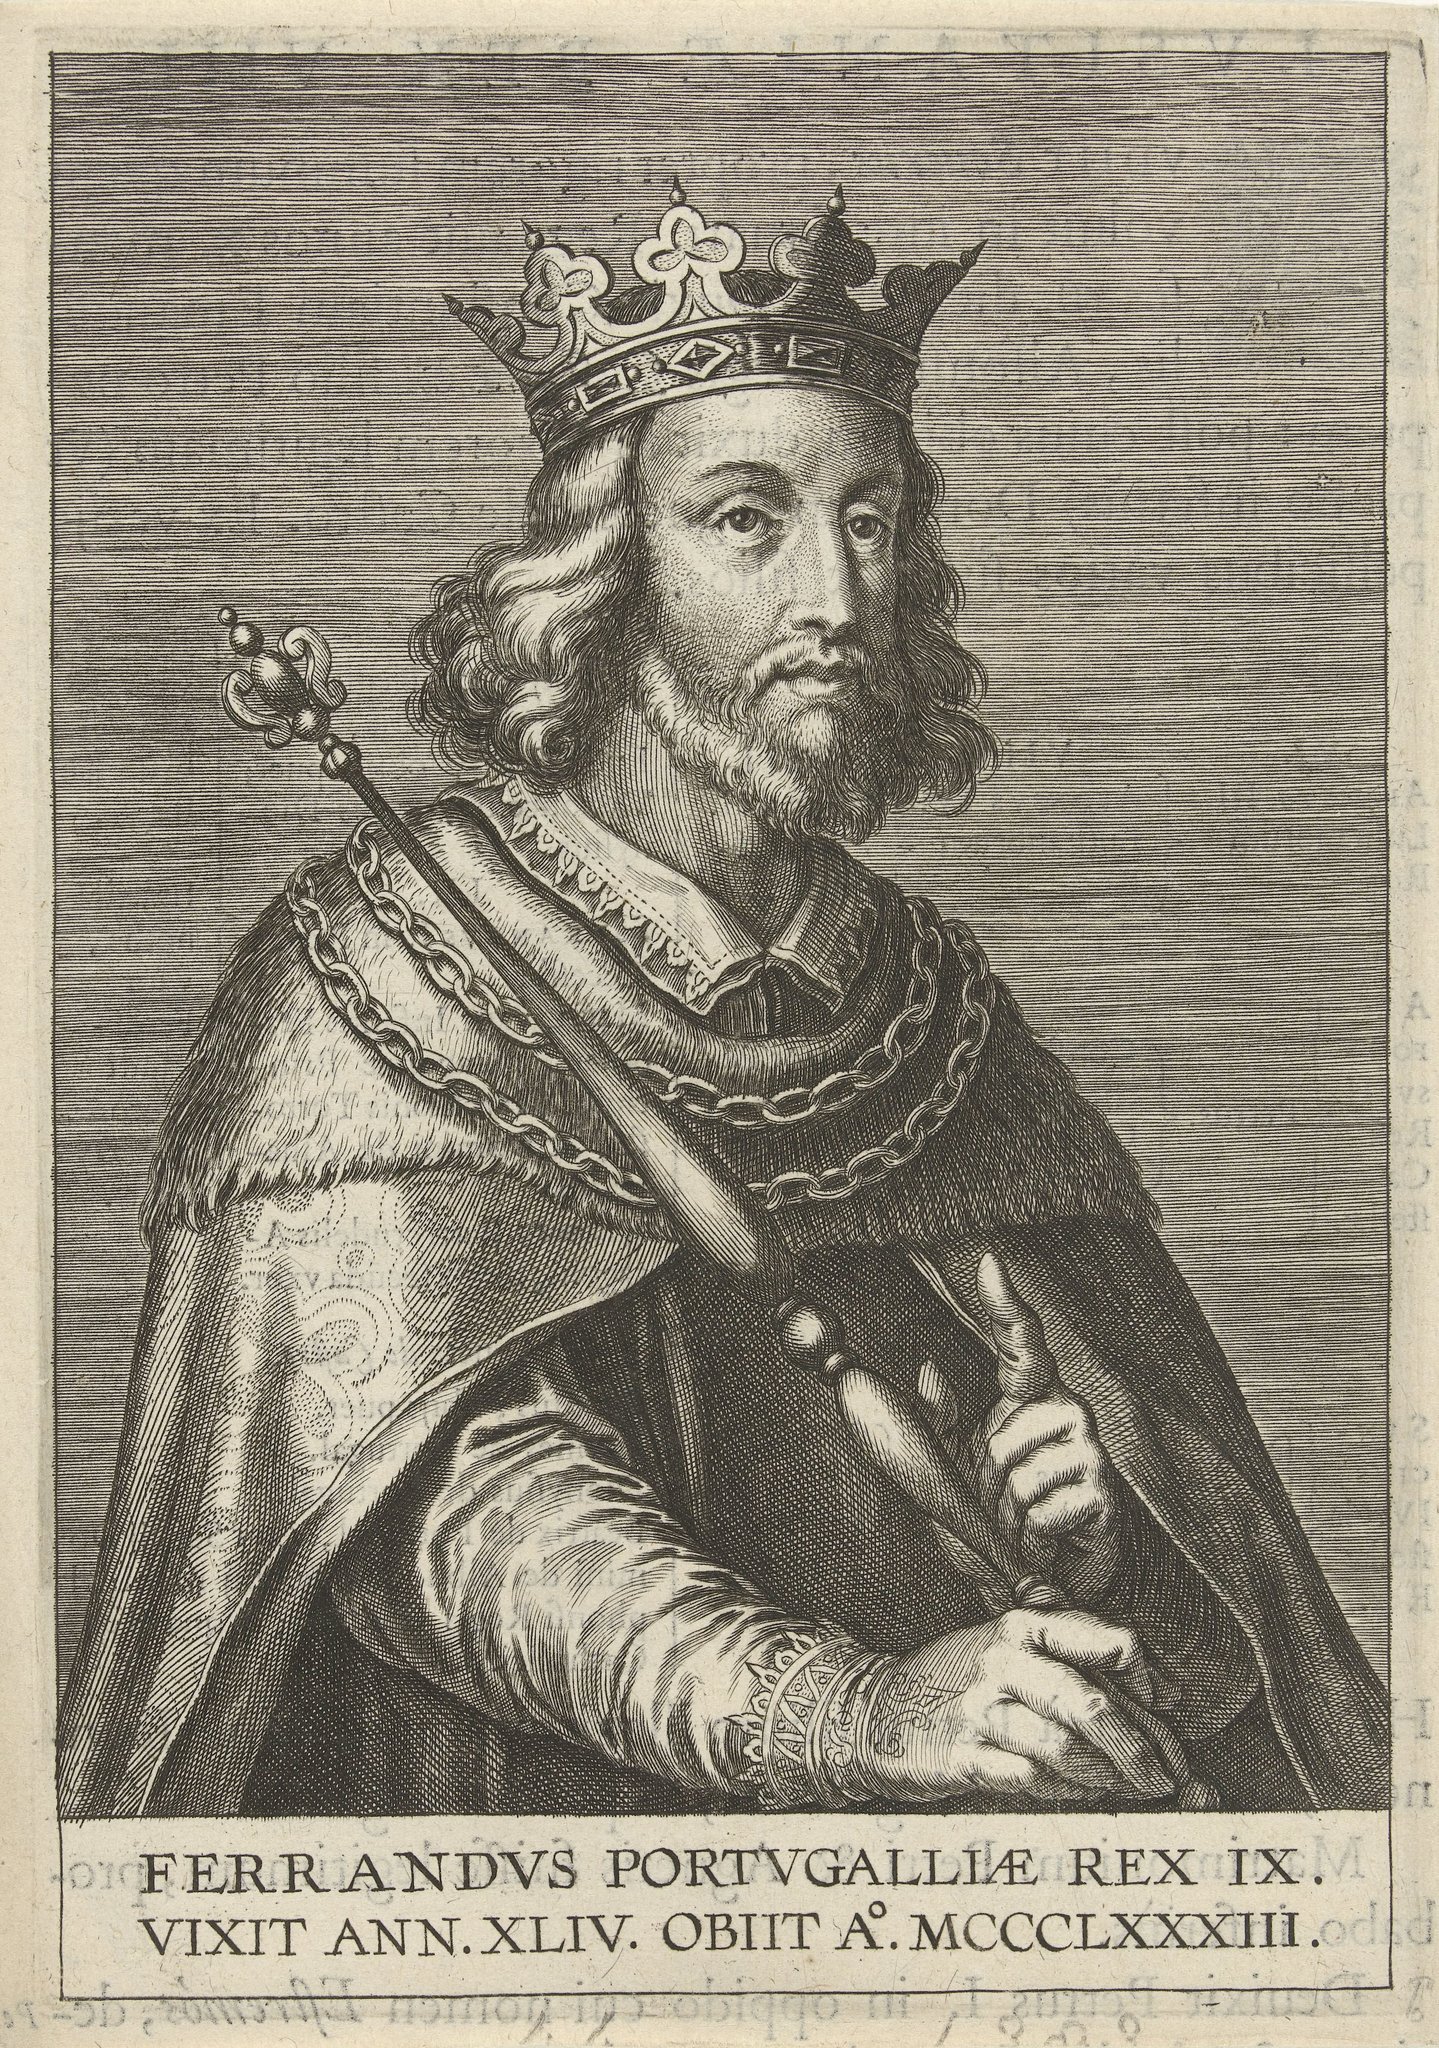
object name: print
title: Koningen en prinsen van Portugal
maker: cornelis galle (i)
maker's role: print maker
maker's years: 1576-1650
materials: paper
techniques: engraving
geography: southern netherlands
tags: insignia and symbols of sovereignty (crown, diadem, sceptre, orb, seal, standard, cloak, pectoral)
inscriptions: collector's mark: Lugt 2228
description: Illustratie voor: Antonio Vasconcellos. Anacephalæoses id est, Svmma captia actorvm regvm Lvsitaniæ. Antwerpen: Petrus II en Joannes II Bellerus, 1621, of latere druk.